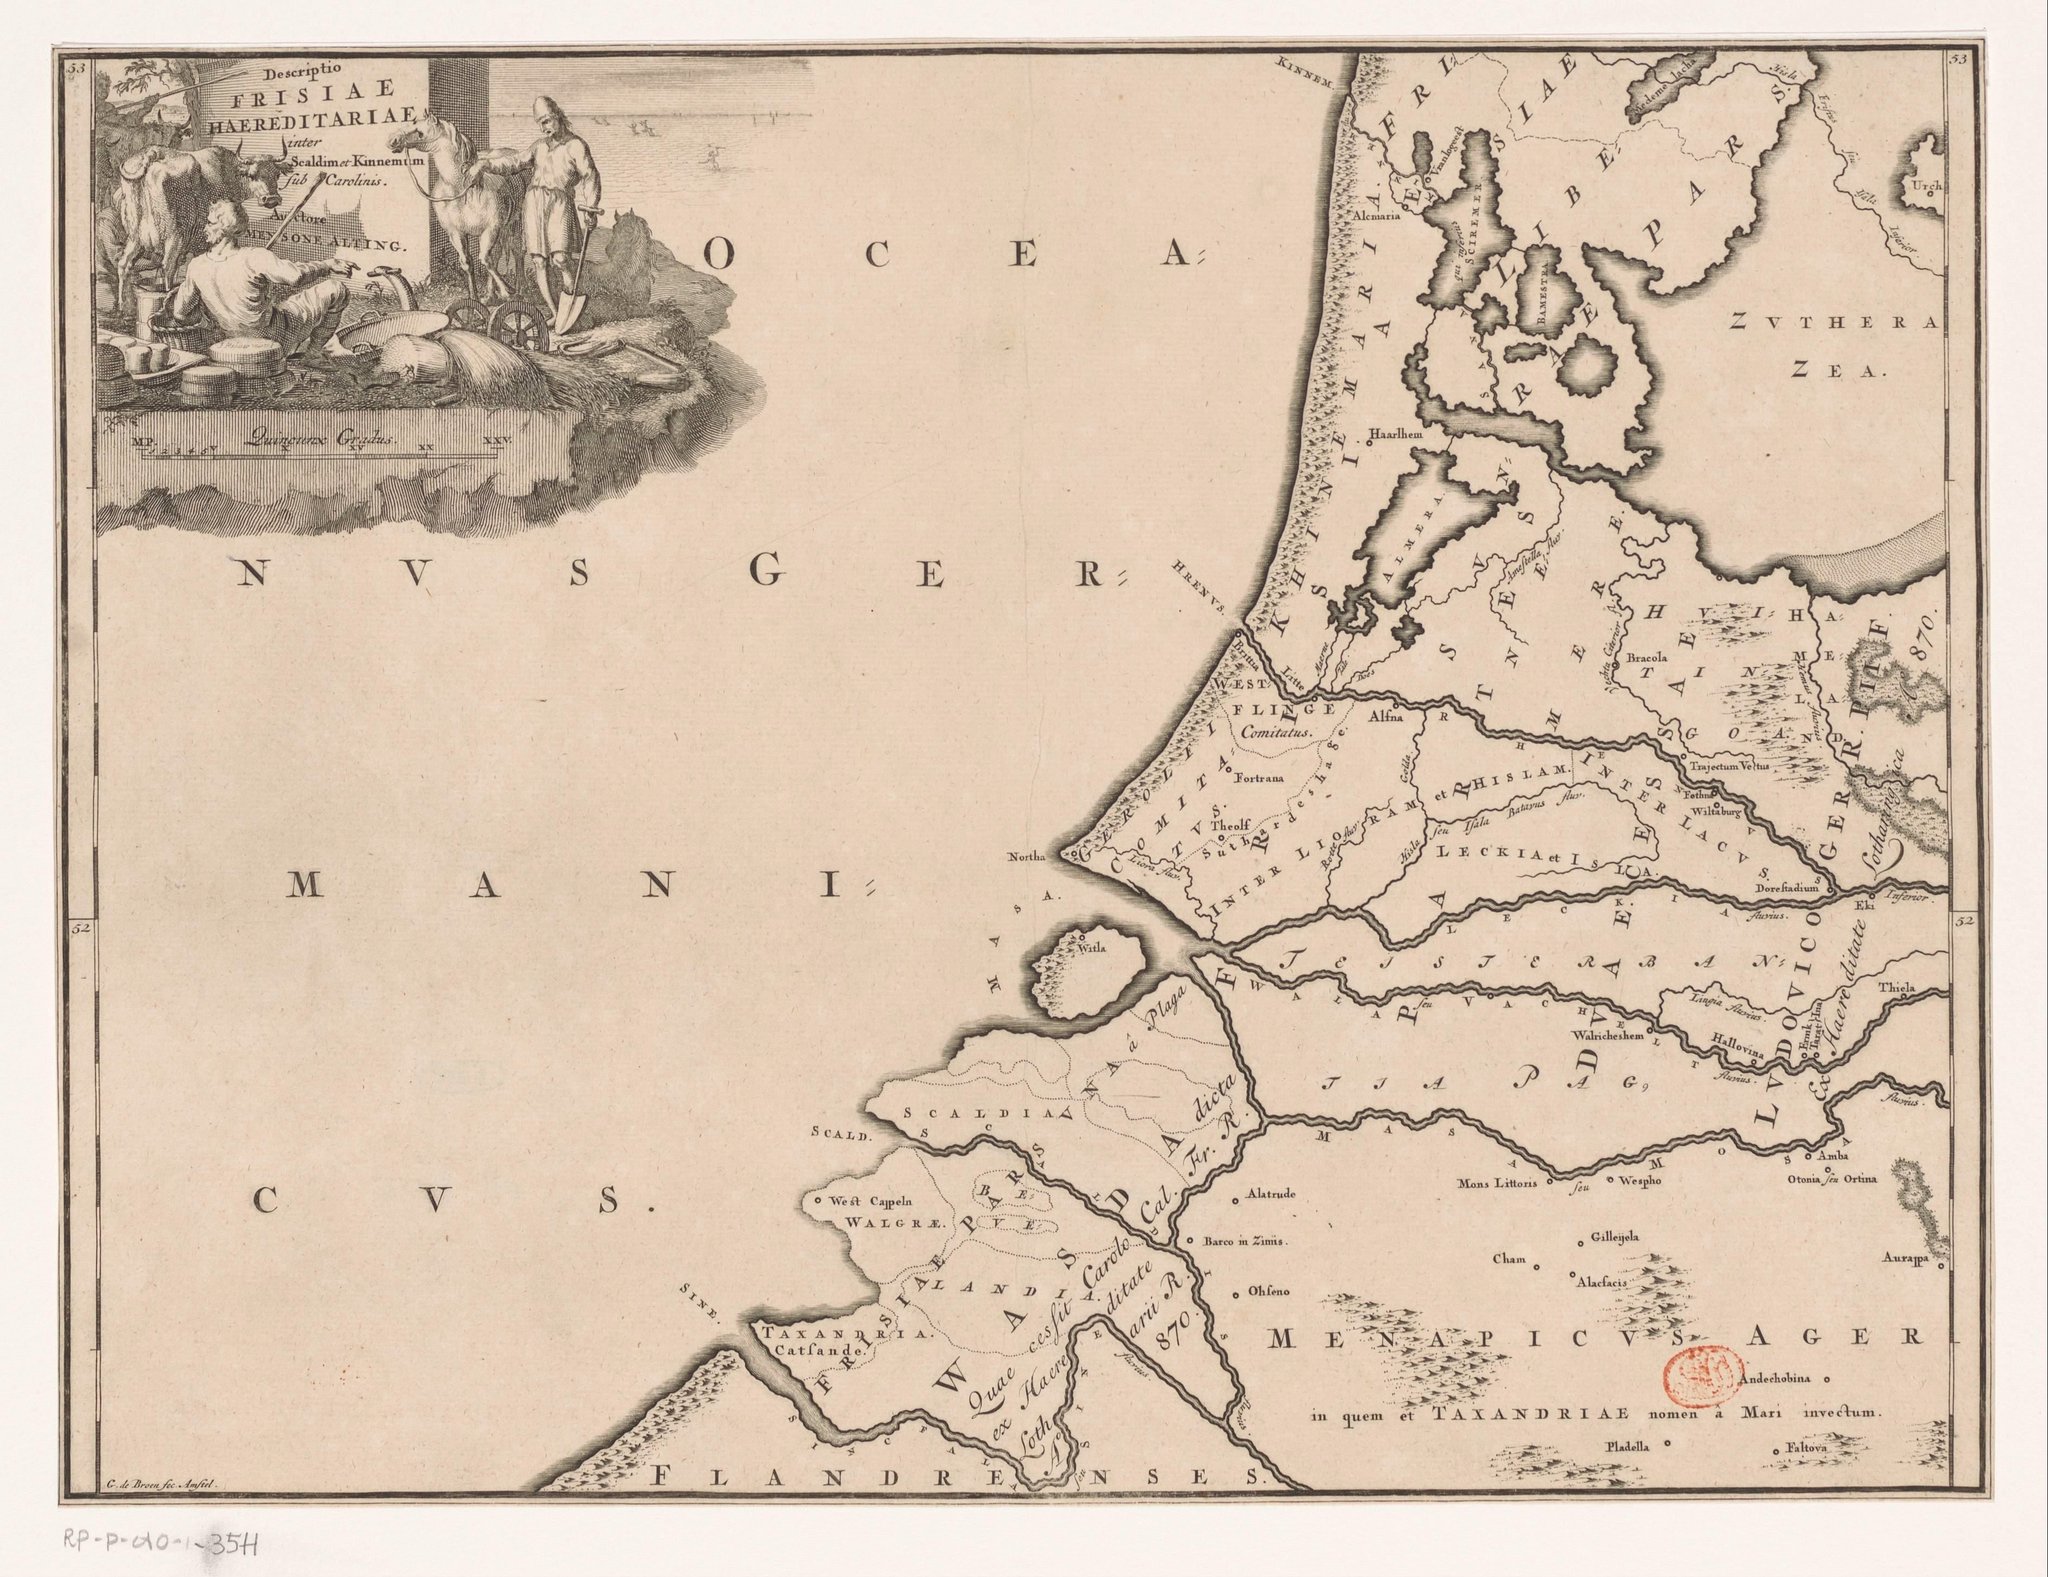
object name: history print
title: Historische kaart van Nederland met de gebieden van de Bataven en Friezen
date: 1697-1700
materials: paper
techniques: engraving, etching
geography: amsterdam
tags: maps of separate countries or regions, netherlands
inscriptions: collector's mark: Lugt 2228, collector's mark: Lugt 195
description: Maakt deel uit van 16 kaarten van het land van de Bataven en de Friezen eerst vervaardigd voor en opgenomen in Alting, Menso. Descriptio, secundum antiquos, agri Batavi & Frisii. 2 delen. Amsterdam: Henricus Wetstein, 1697-1700. Hergebruikt in Halma, François. Tooneel der Vereenigde Nederlanden, en onderhorige landschappen (...). 2 delen. Leeuwarden: Hendrik Halma, 1725. Deze kaart is gebruikt in Halma's Tooneel der Vereenigde Nederlanden (1725) en is waarschijnlijk te vinden in deel 1, p. 335.